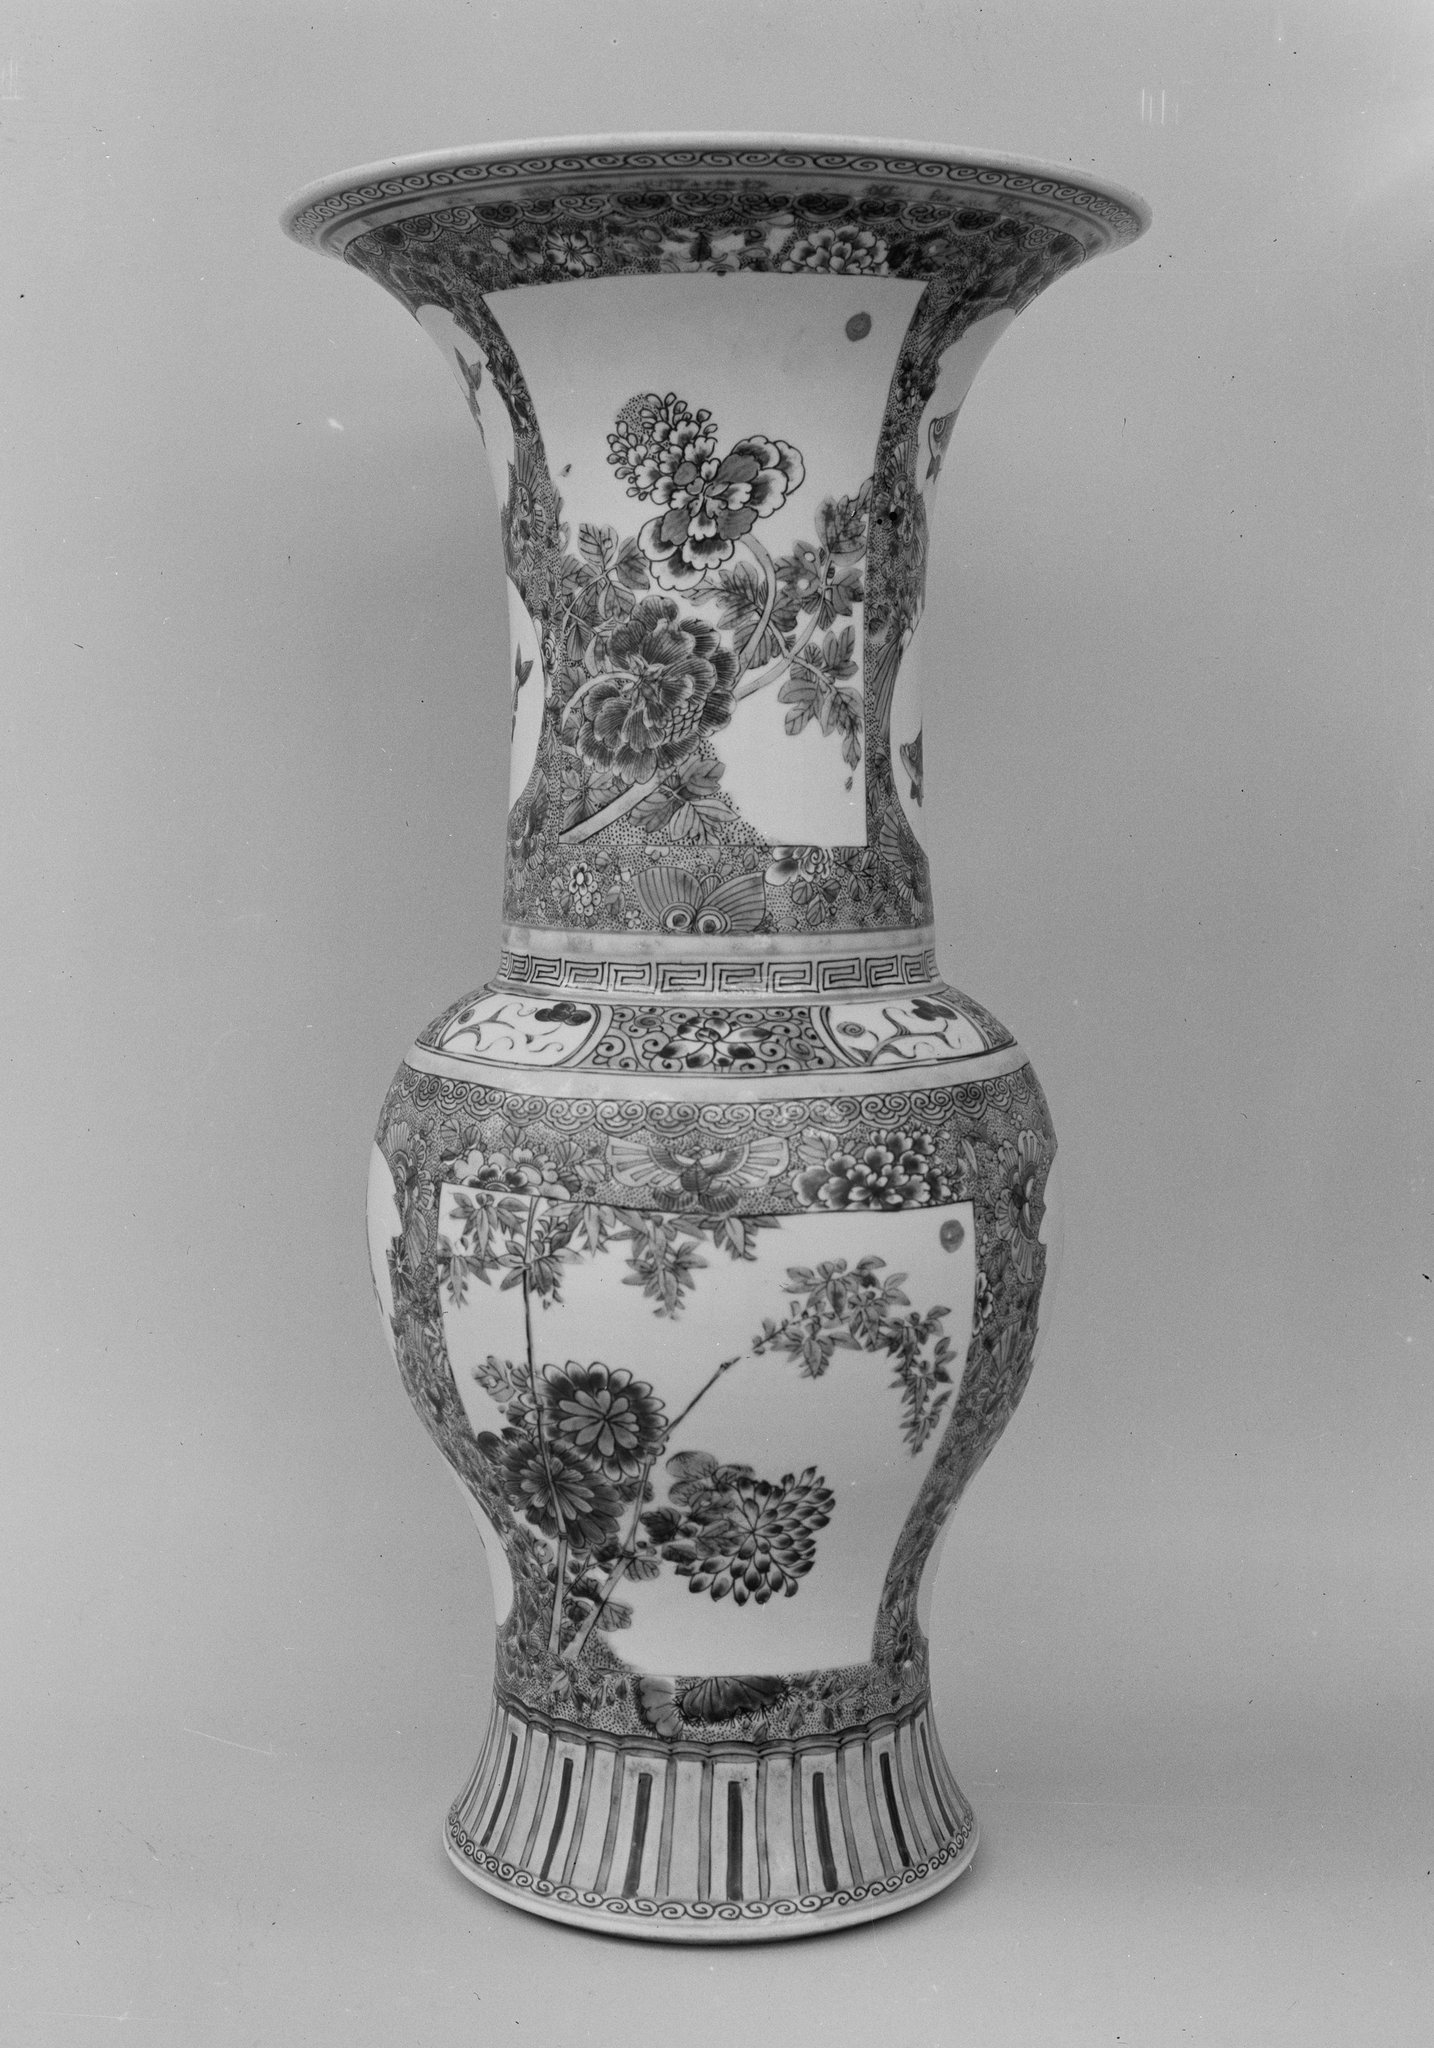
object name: vase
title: Vase decorated with flowers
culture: chinese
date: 1662-1722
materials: enamel, porcelain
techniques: overglaze, painting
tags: flowers